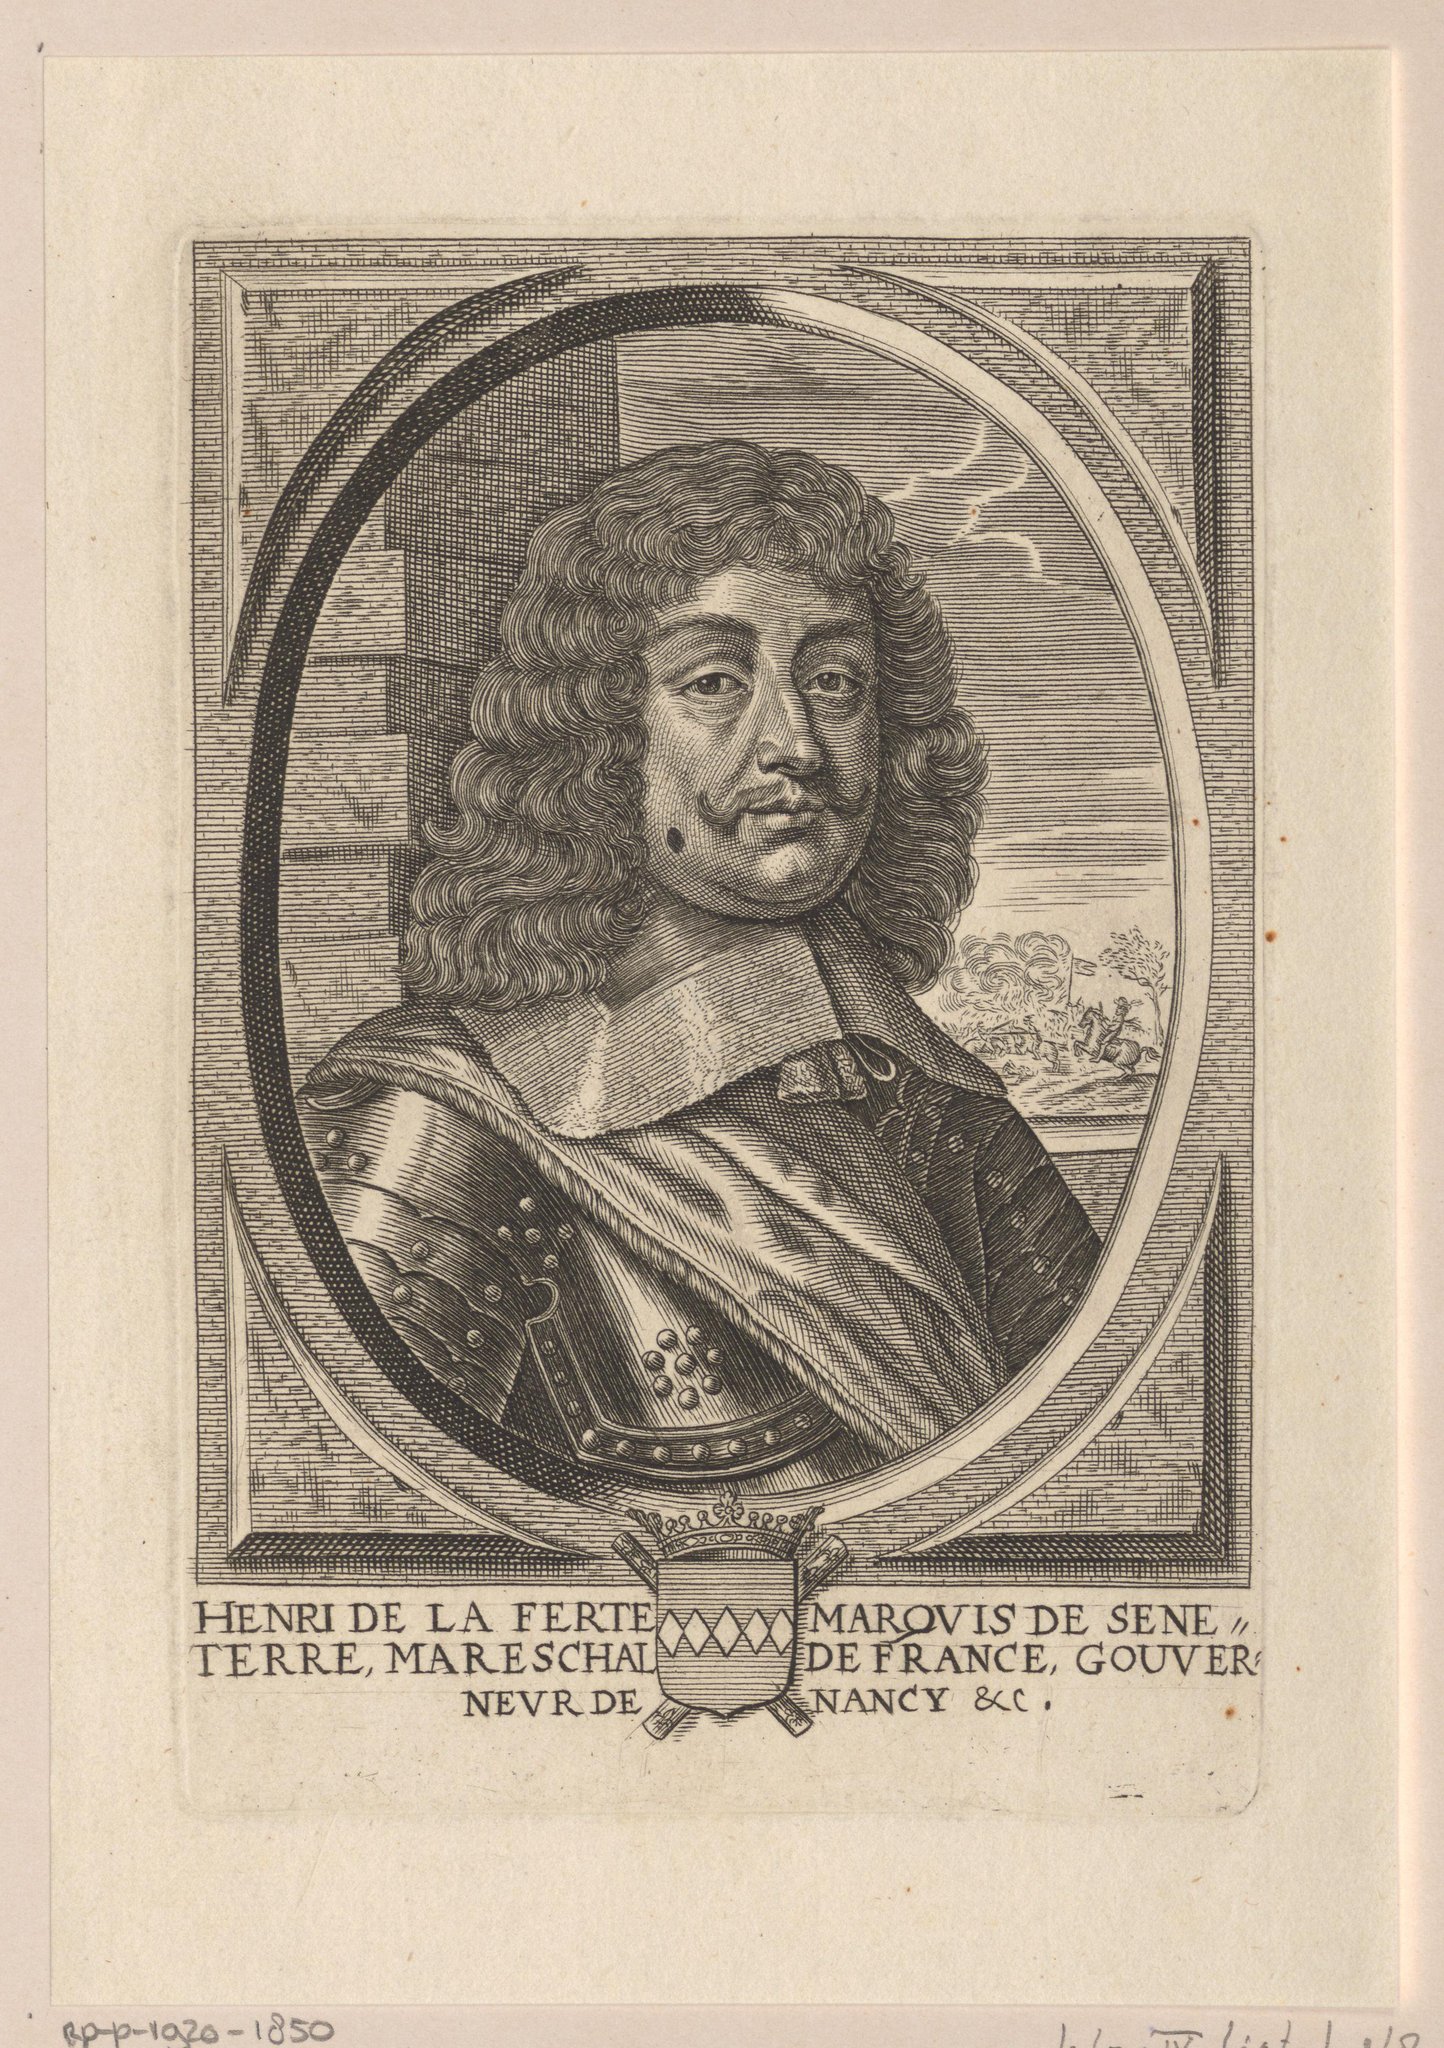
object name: print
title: Portret van Henri de la Ferté-Senneterre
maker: Anonymous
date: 1665-1699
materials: paper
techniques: engraving, etching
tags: politician, commander-in-chief, general, marshal, historical persons, armorial bearing, heraldry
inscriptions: collector's mark: Lugt 2228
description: Met drieregelig onderschrift in het Frans.